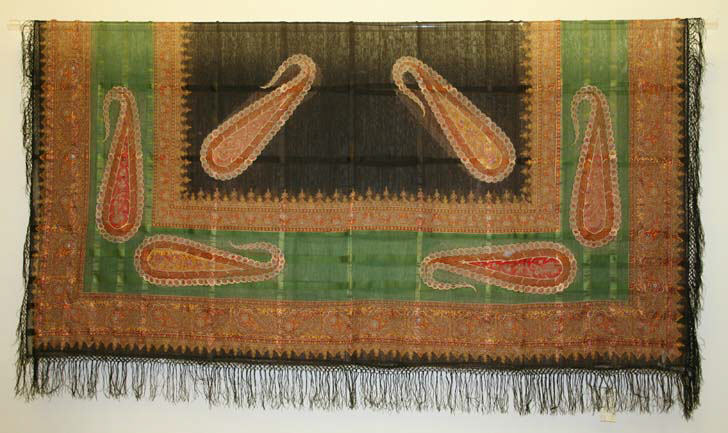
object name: shawl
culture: french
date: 1810-1815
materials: silk, wool